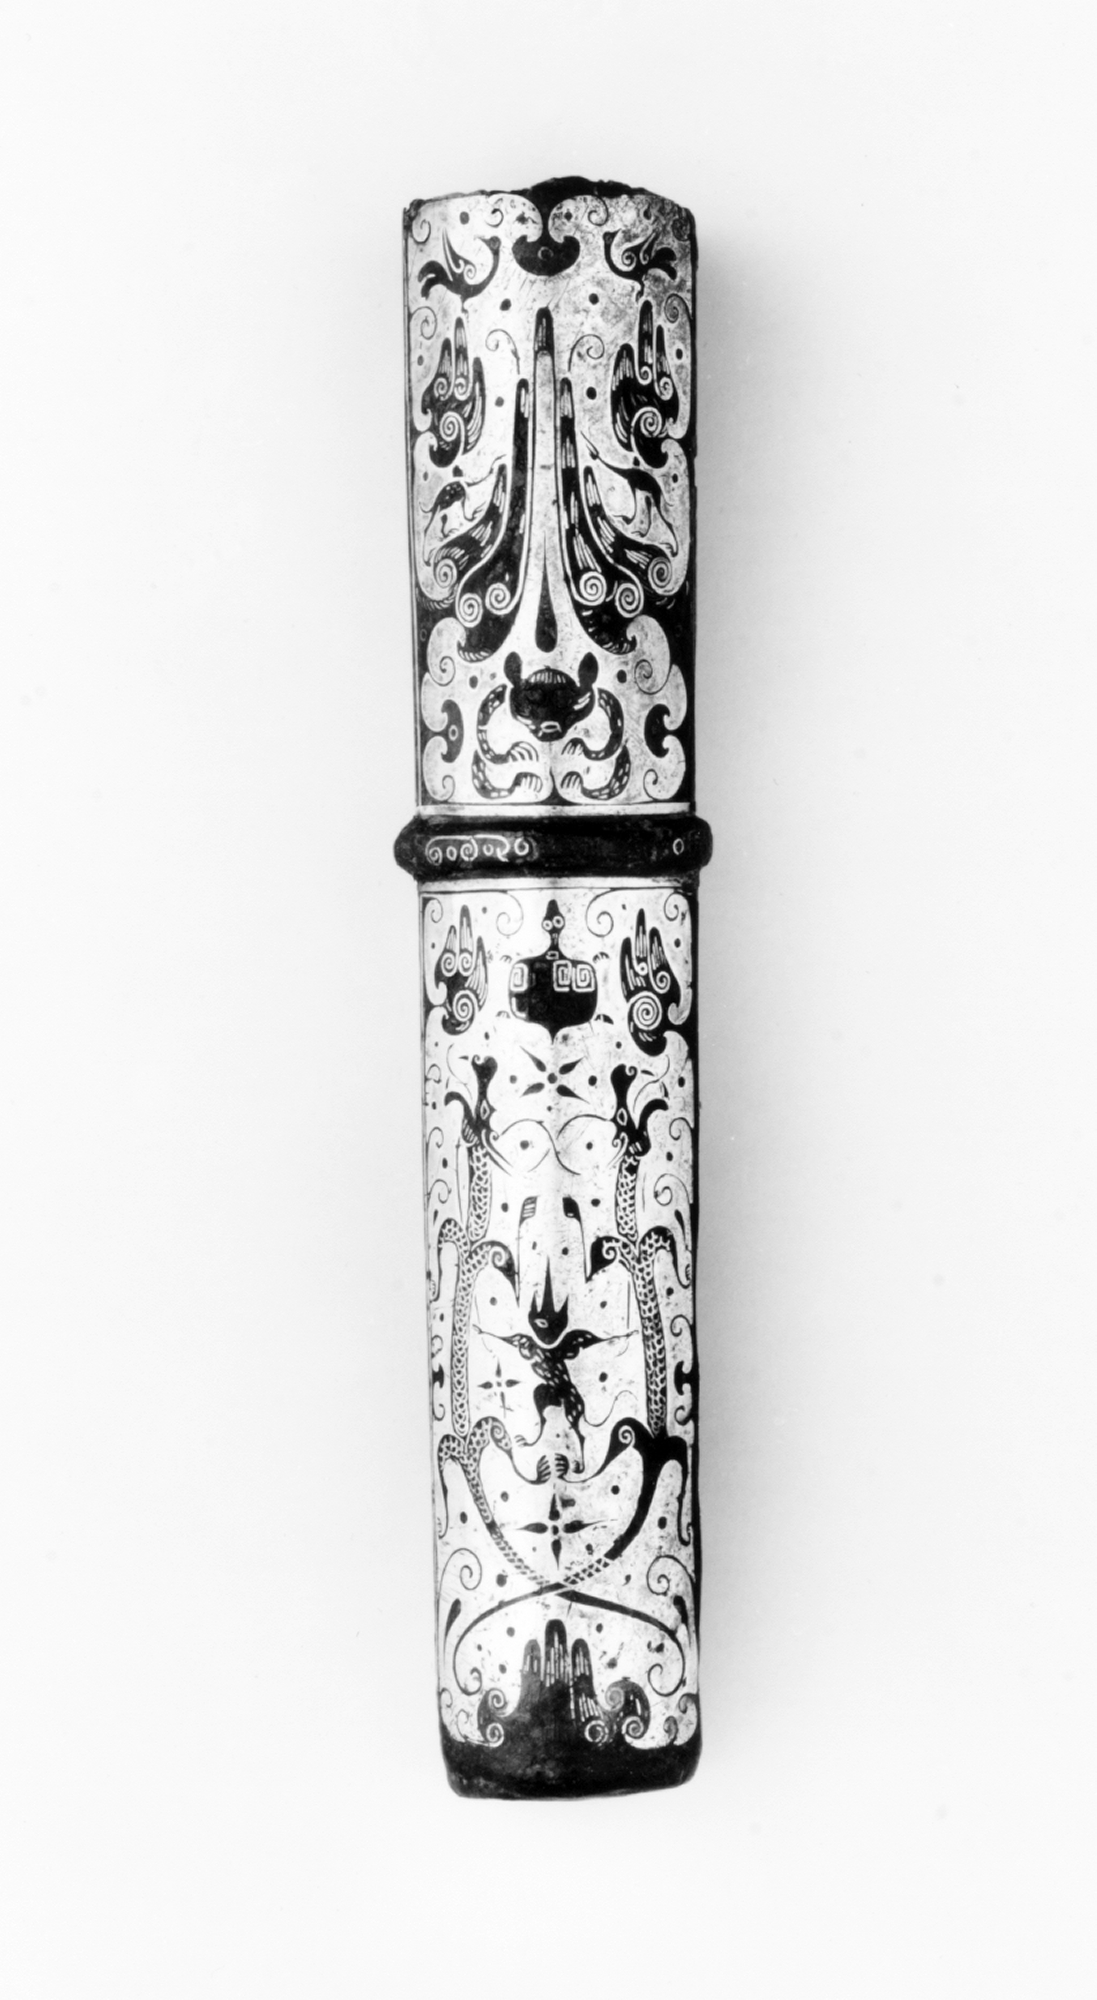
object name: ferrule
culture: chinese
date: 134-68 BCE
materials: bronze, silver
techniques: inlay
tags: birds,dragons